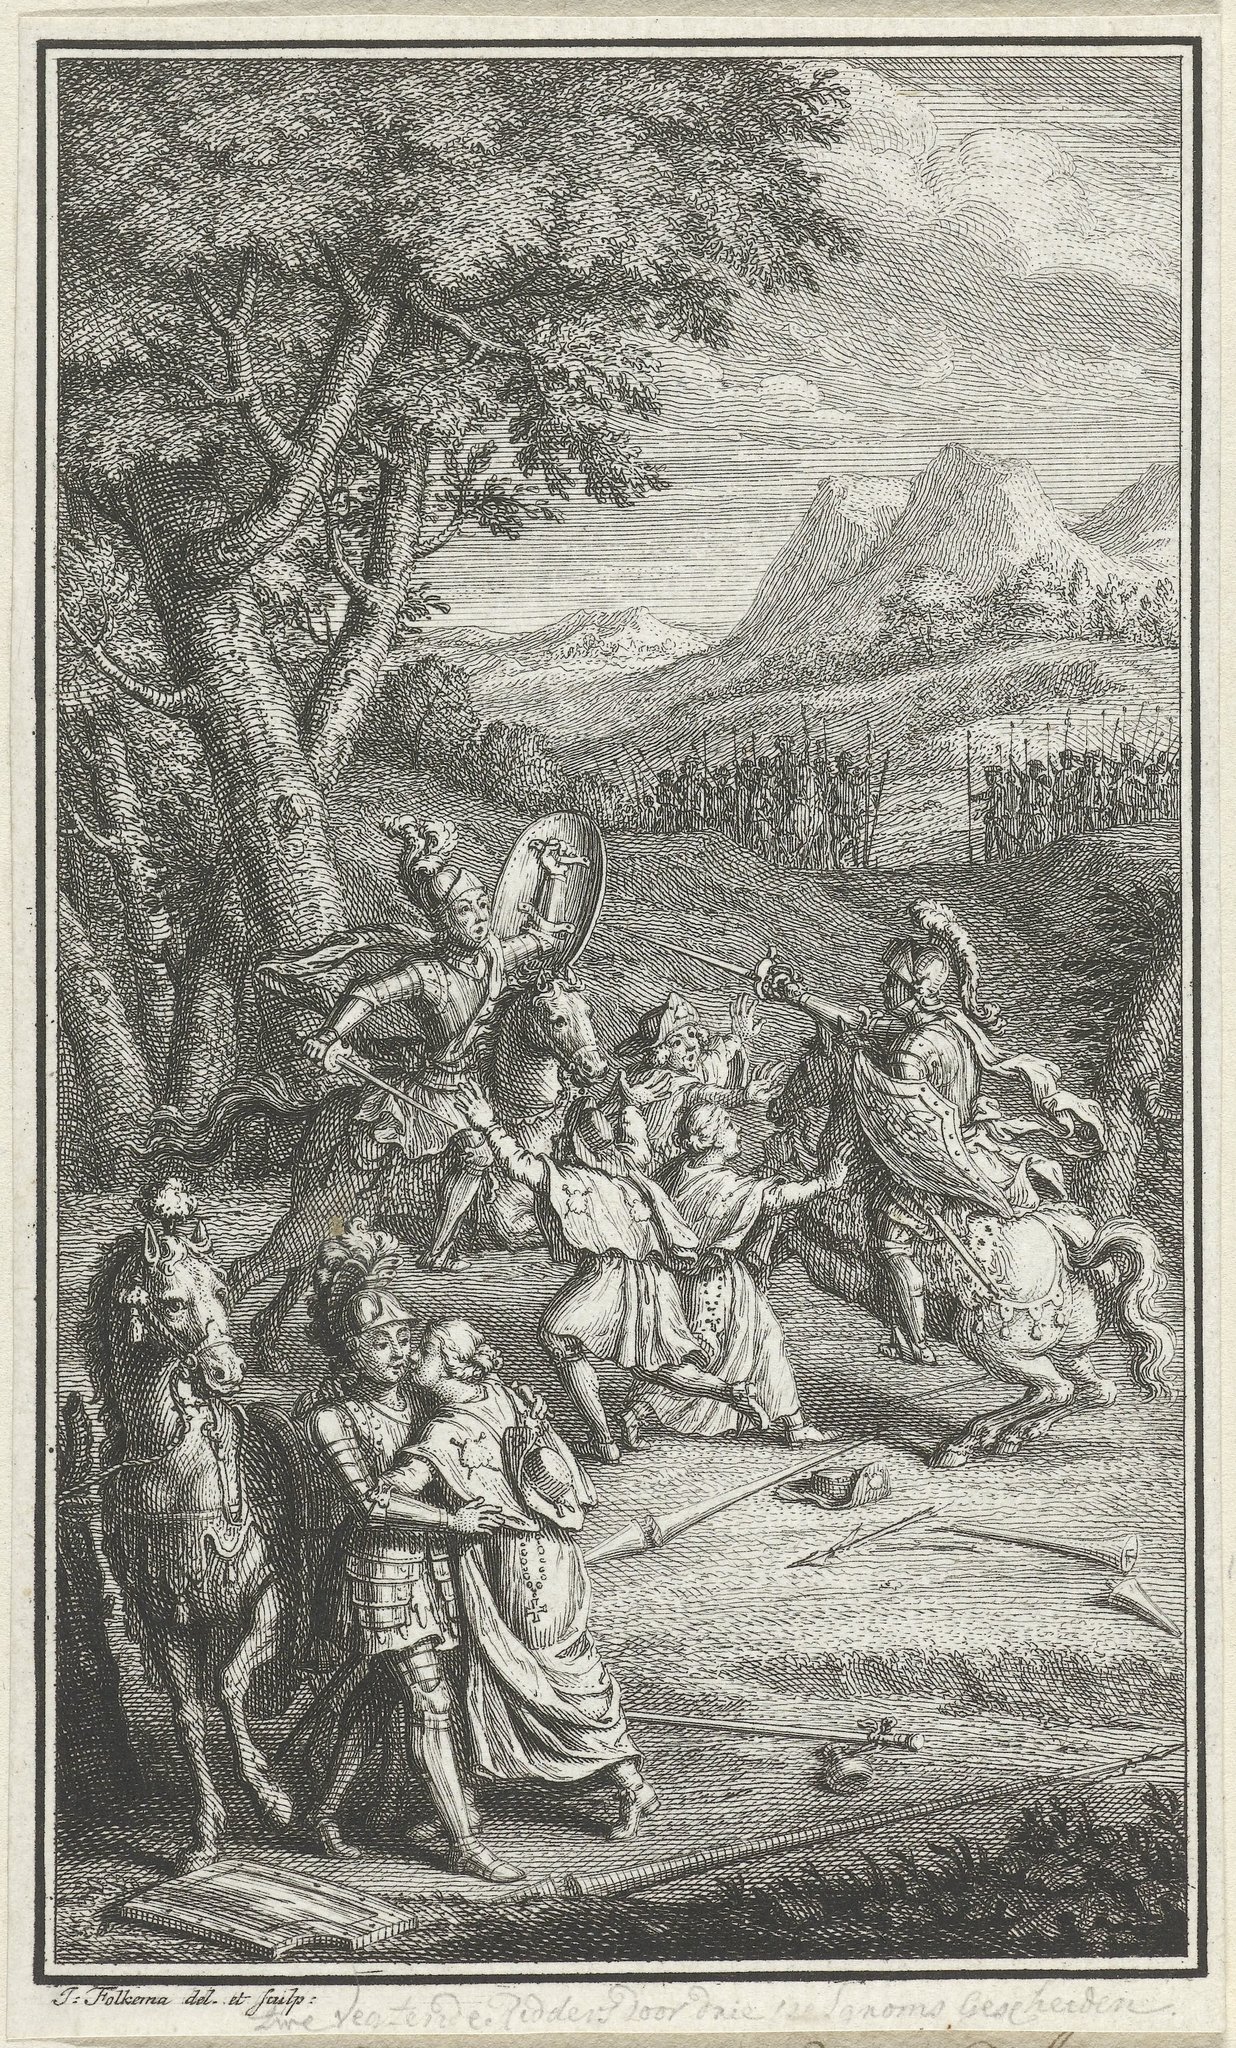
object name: print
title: Ridders in gevecht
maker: jacob folkema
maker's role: draughtsman, print maker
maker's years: 1692-1767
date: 1702-1767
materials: paper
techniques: etching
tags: fighting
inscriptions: inscription: ‘twe vegtende Ridders door drie Pelgroms gescheiden’, inscription: ‘Twee vegtende Ridders door drie Pelgroms gescheiden’, collector's mark: Lugt 2228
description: Drie figuren proberen twee strijdende ridders te paard uit elkaar te houden. Op de voorgrond omhelst een van zijn paard afgestapte ridder een vrouw.